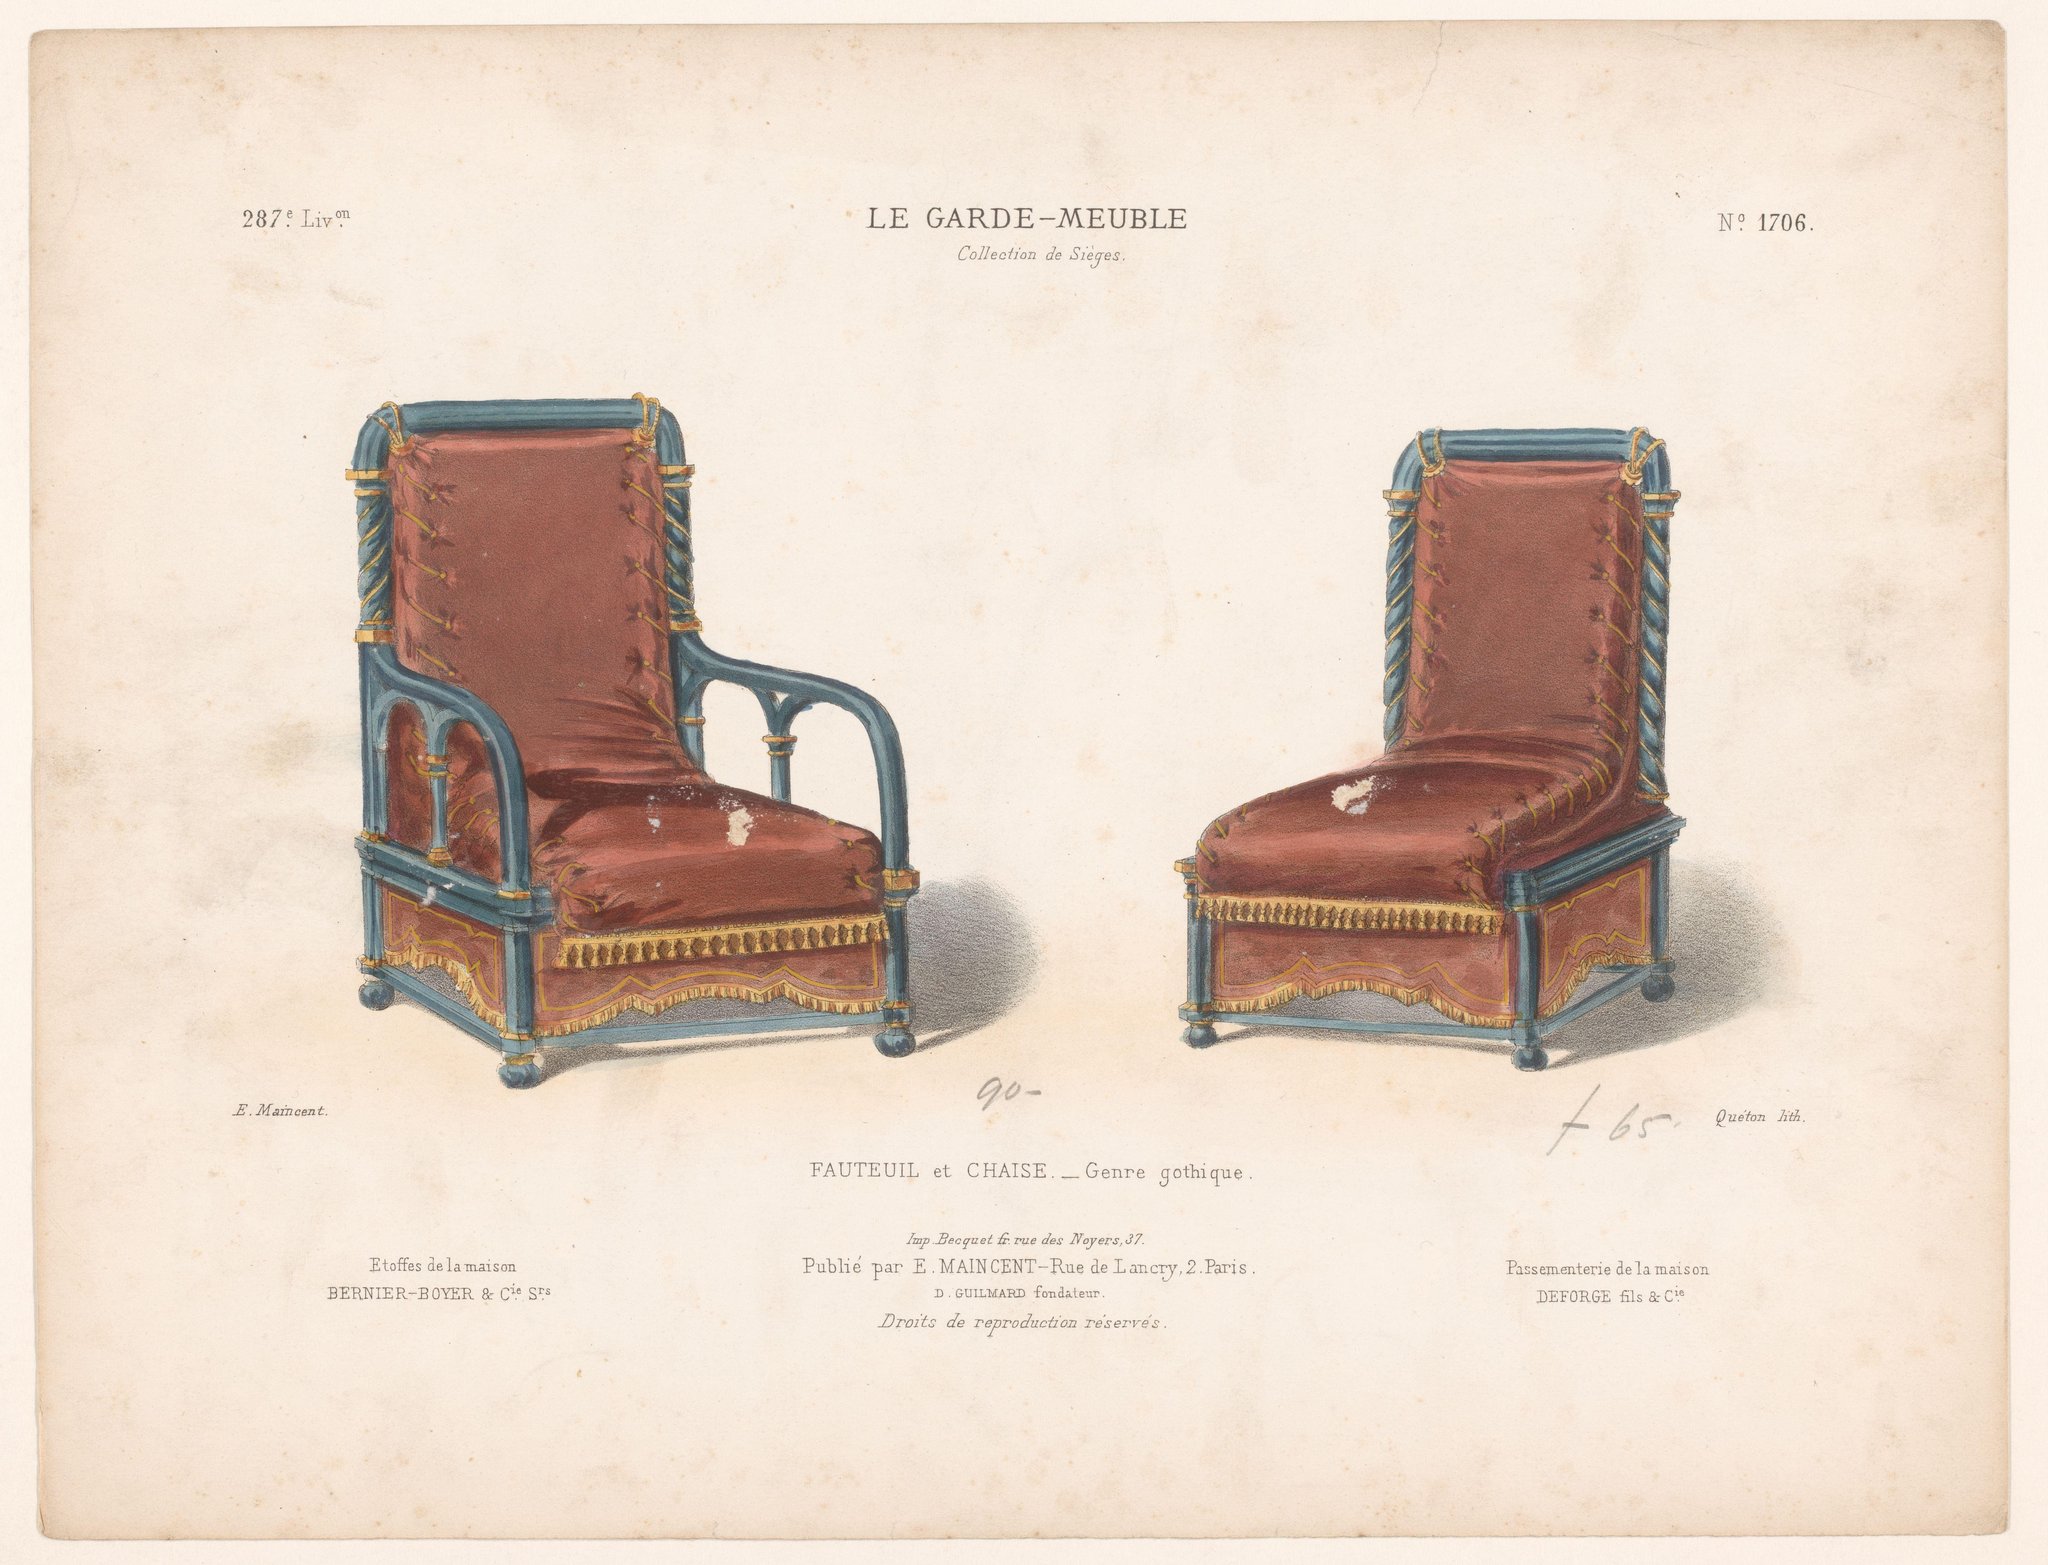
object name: print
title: Fauteuil et chaise Genre gothique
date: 1885-1895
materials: paper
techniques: hand coloring, lithograph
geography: paris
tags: seating furniture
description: Ieder Livraison in de serie Le Garde-Meuble bevat negen platen: drie 'sièges' (zitmeubels), drie 'meubles' (diverse meubels zoals tafels en kasten) en drie 'tentures' (gordijnen en draperieën).